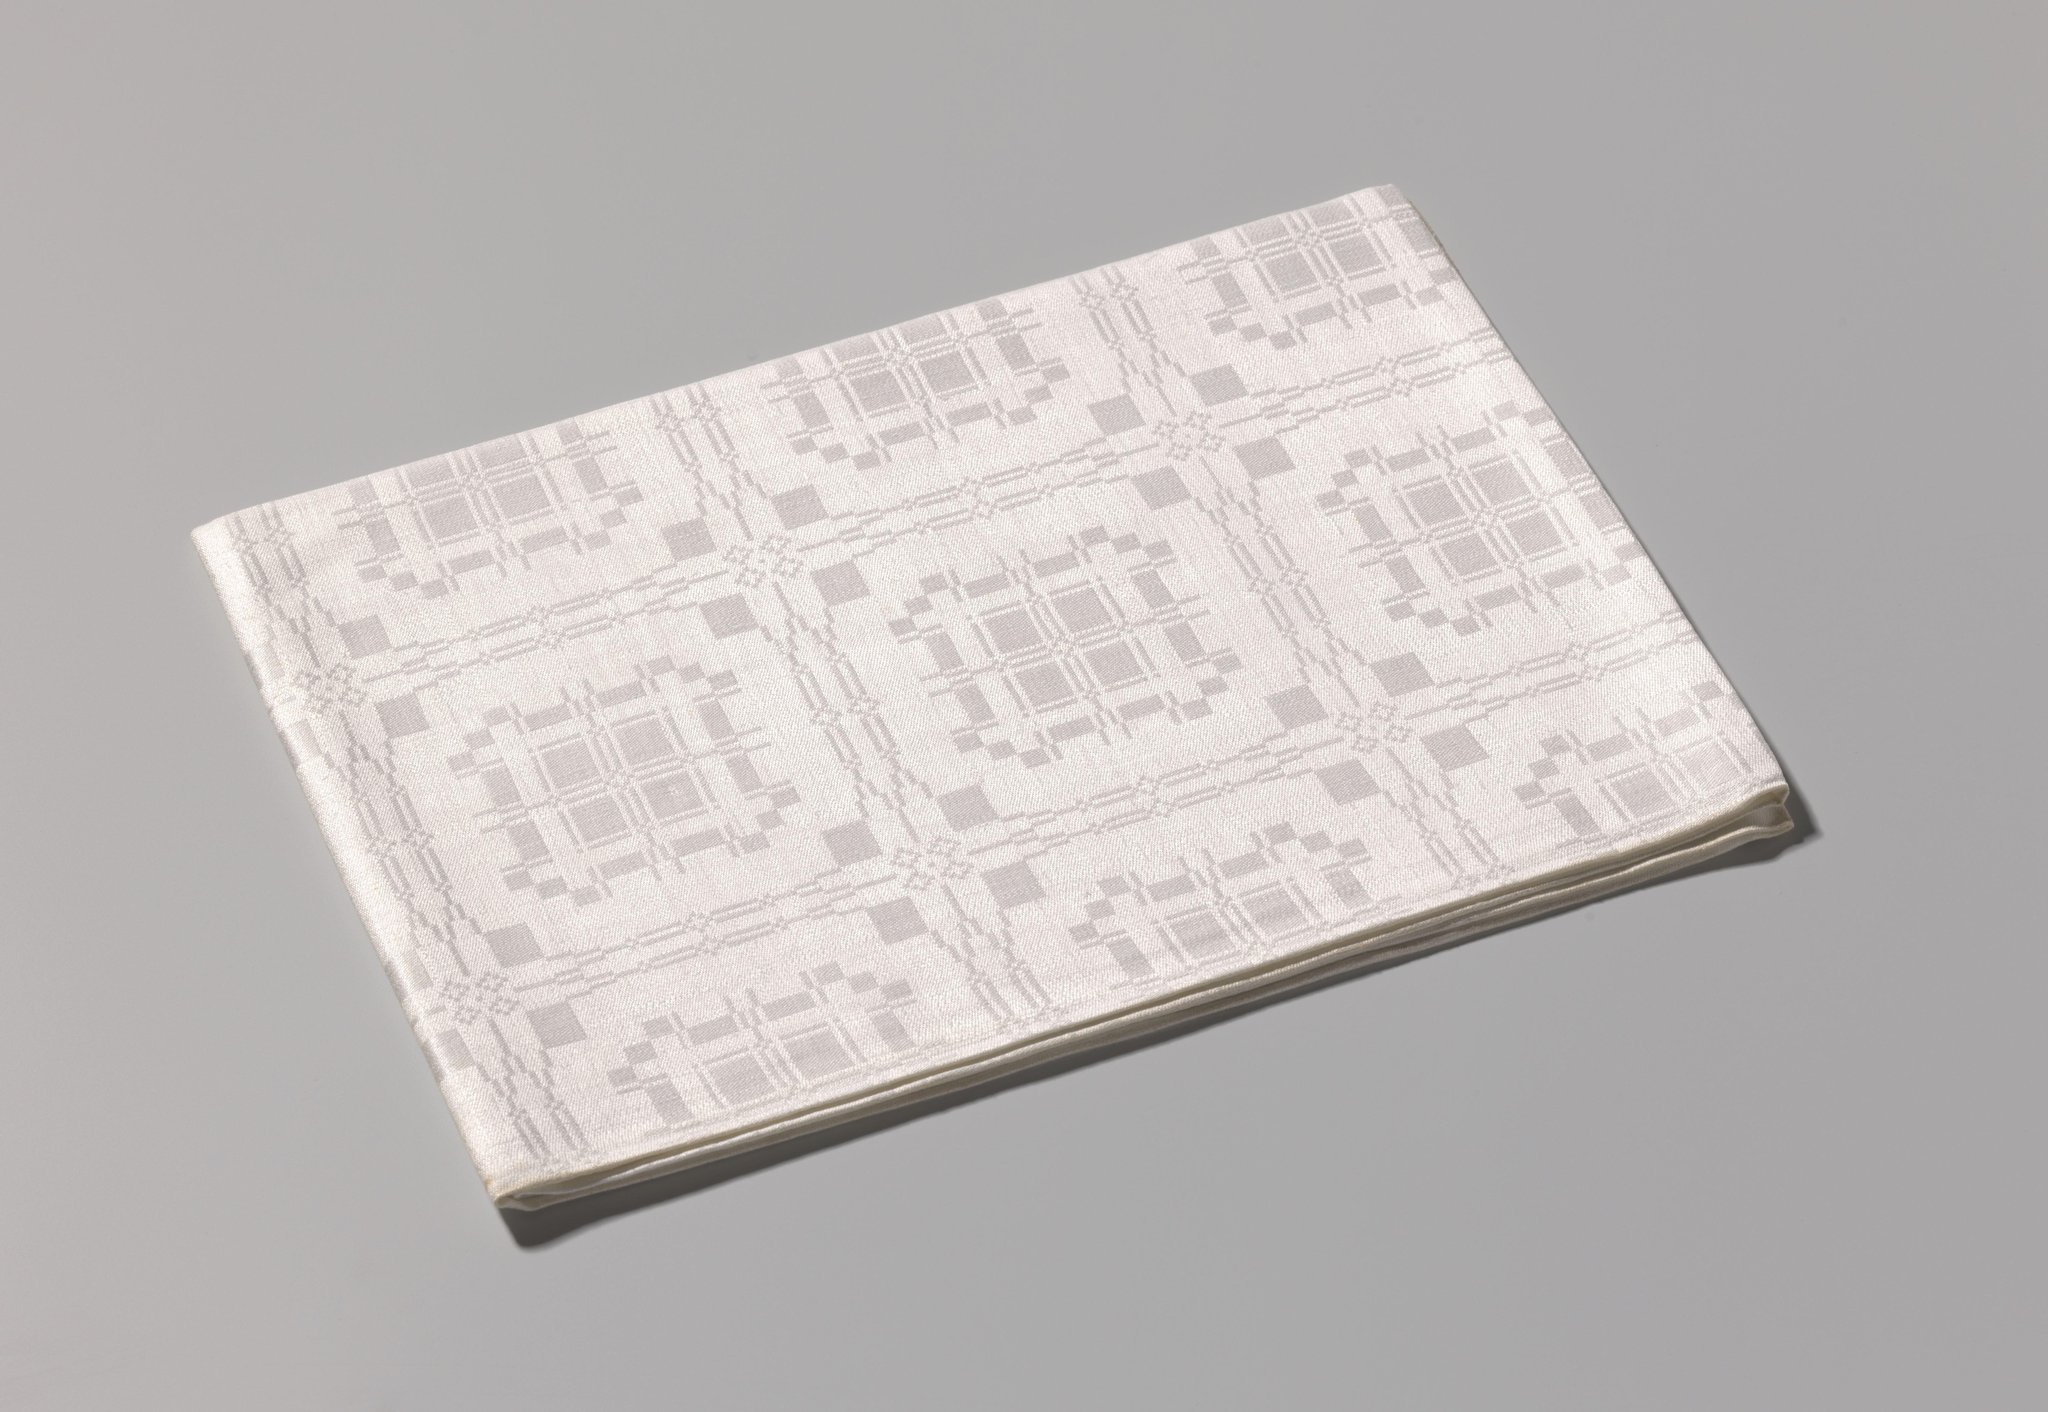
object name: napkin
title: Servet van linnen met pellenpatroon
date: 1400-1950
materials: linen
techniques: peeled fabric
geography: northern netherlands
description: Wit linnendamasten servet met pellenpatroon, merk kroon IS en 36.